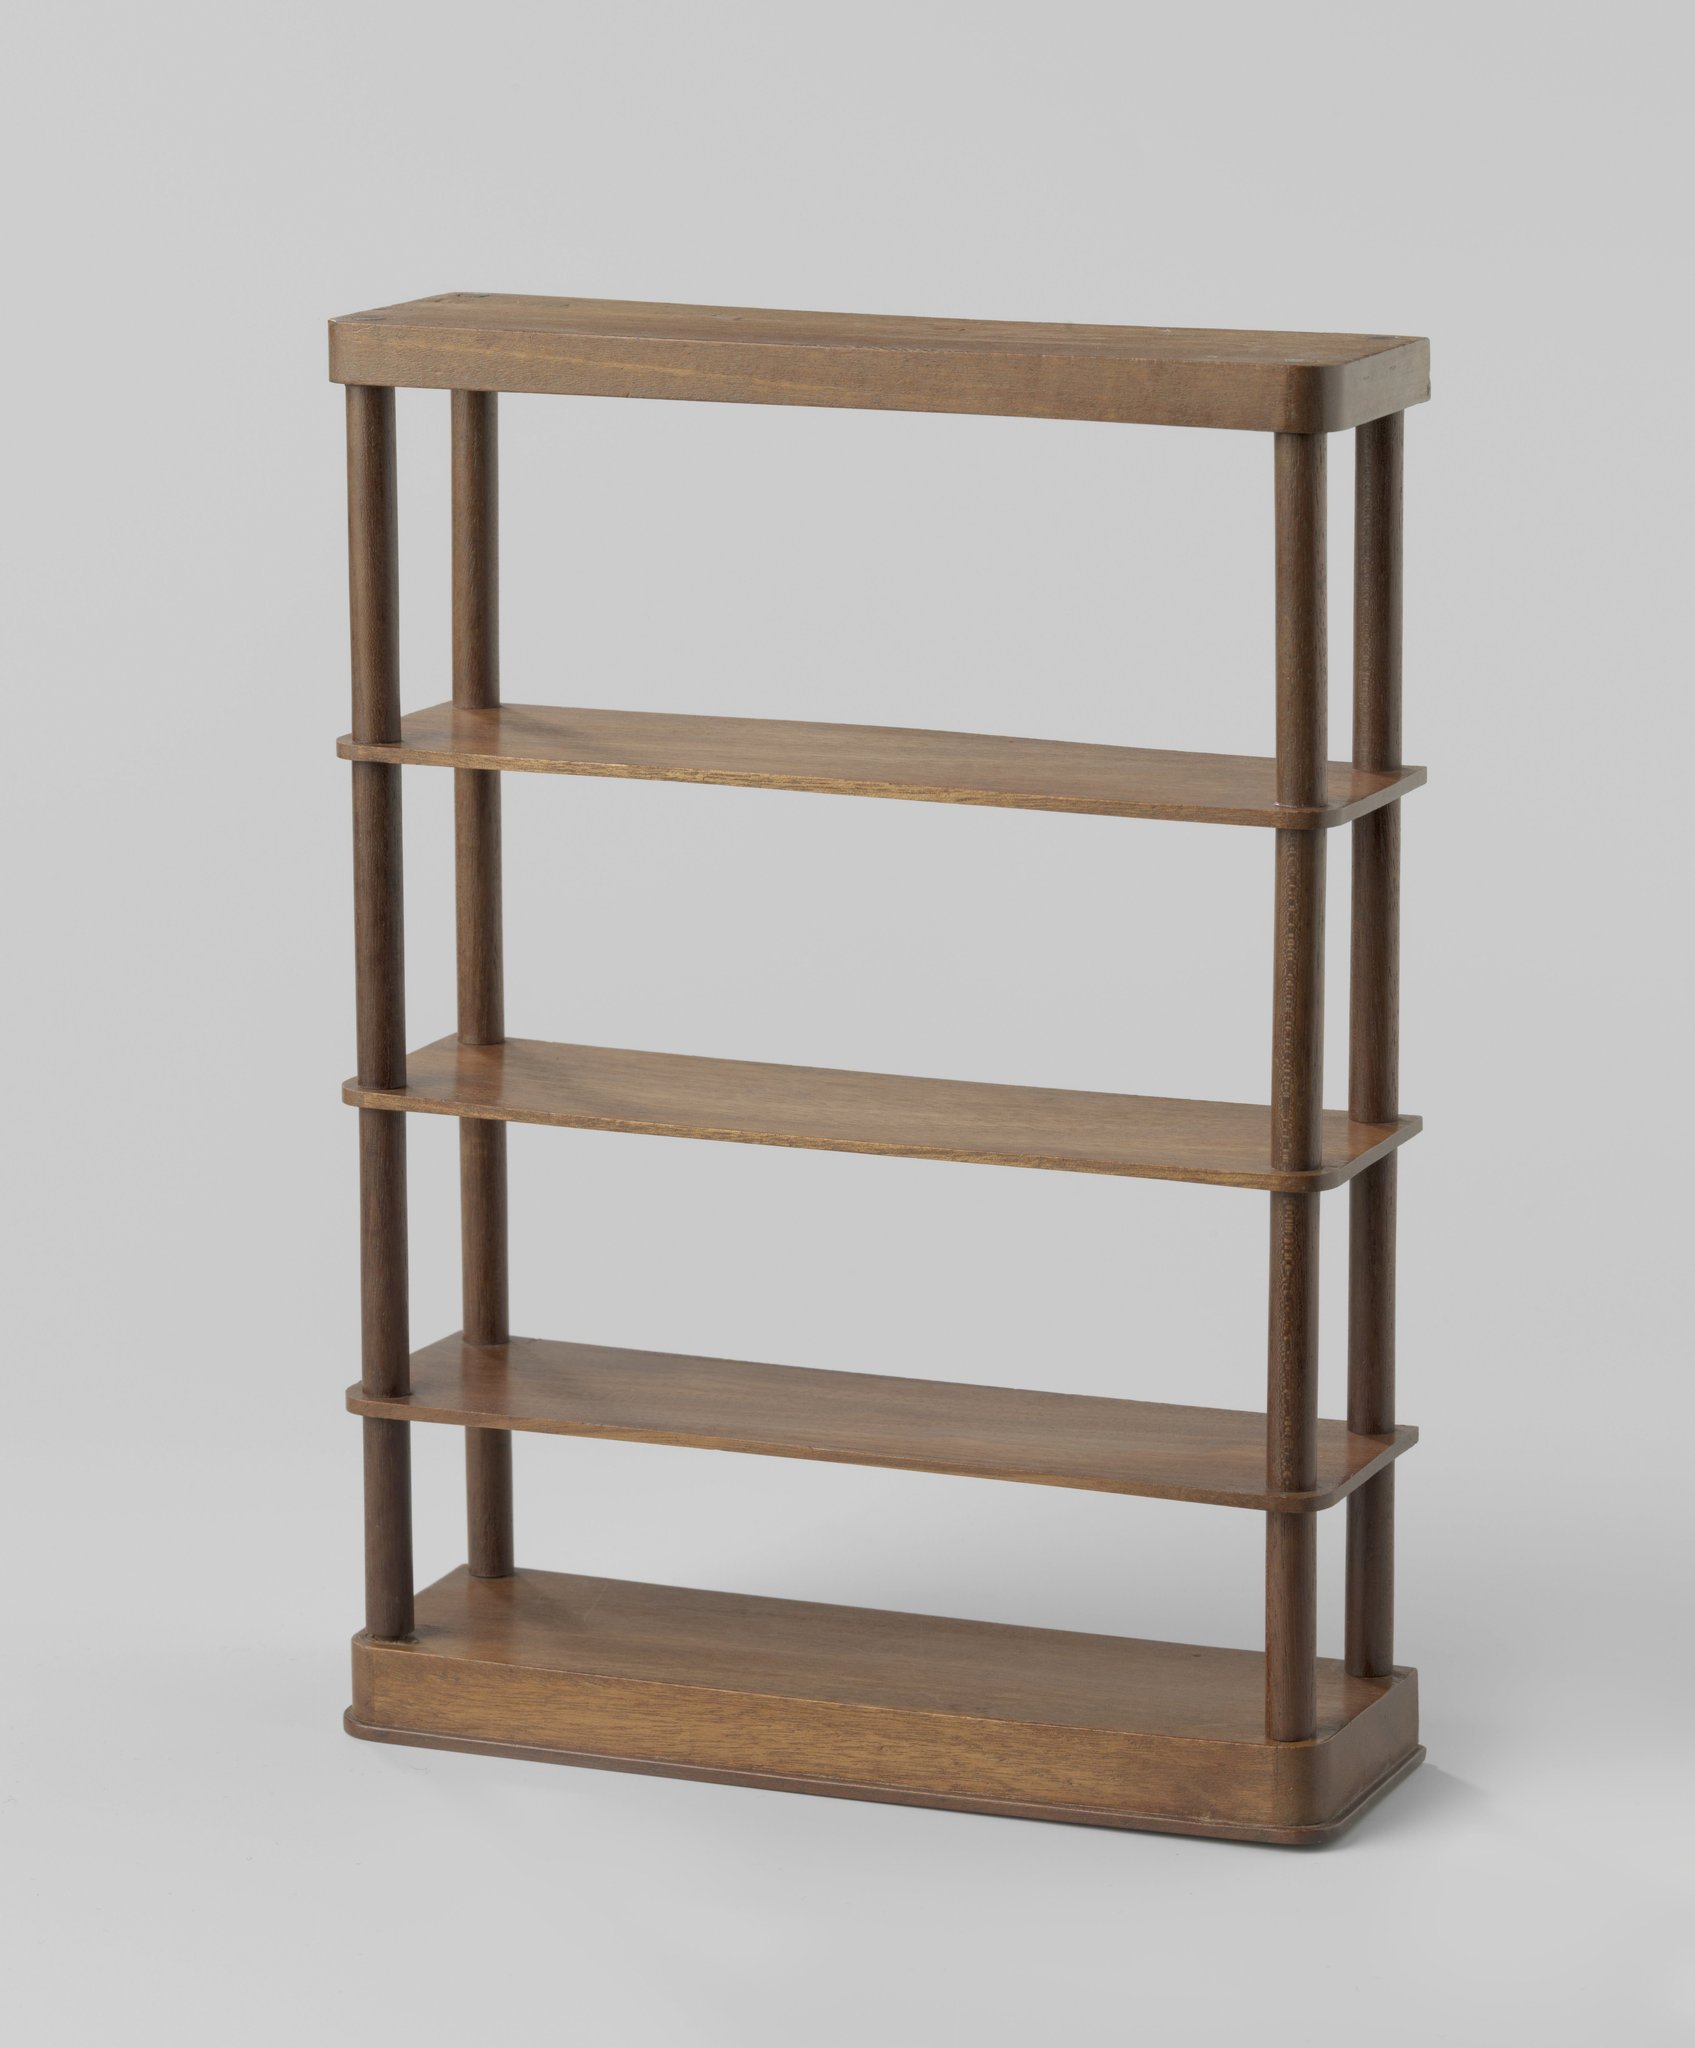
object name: stellingkast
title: Stellingkast met drie planken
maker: Anonymous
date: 1820-1840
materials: wood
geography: amsterdam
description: Stellingkast van mahoniehout, bestaande uit zware massieve plint, drie planken en een massieve kop met dekplaat, onderling verbonden door ronde, gladde stijlen.